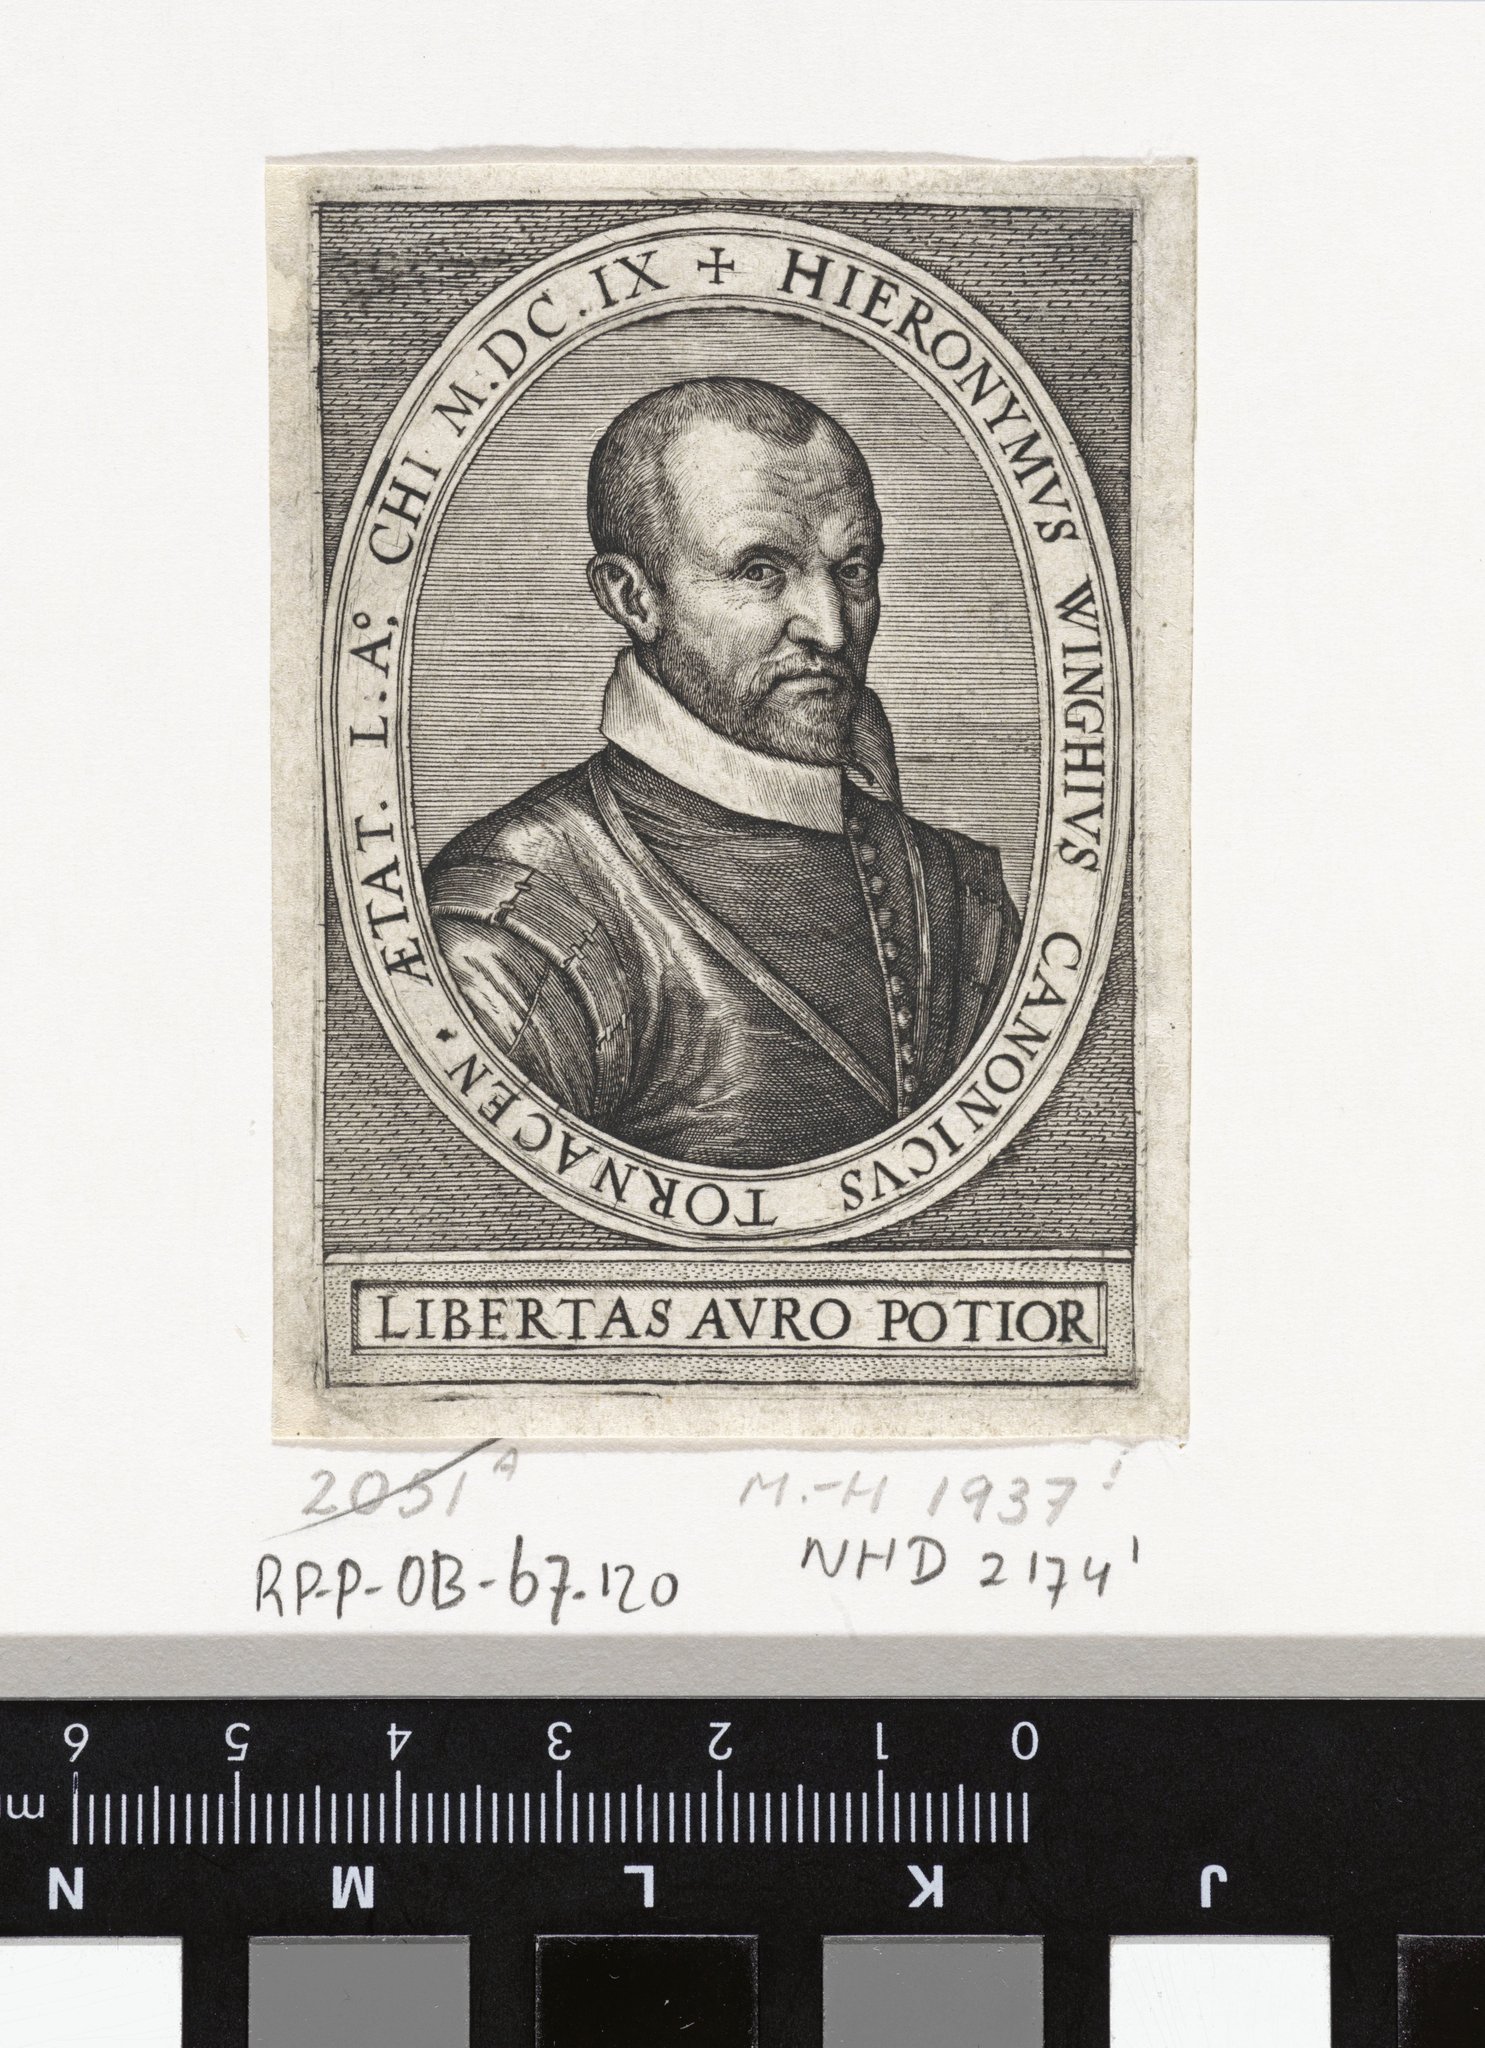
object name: print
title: Portret van de kanunnik Hieronymus van Winghe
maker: johannes wierix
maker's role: draughtsman, print maker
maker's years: 1549-1618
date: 1609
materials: paper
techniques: engraving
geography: antwerp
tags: kanunnik, hieronymus van winghe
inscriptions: collector's mark: Lugt 2228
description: In het kader onder zijn portret een motto in het Latijn.